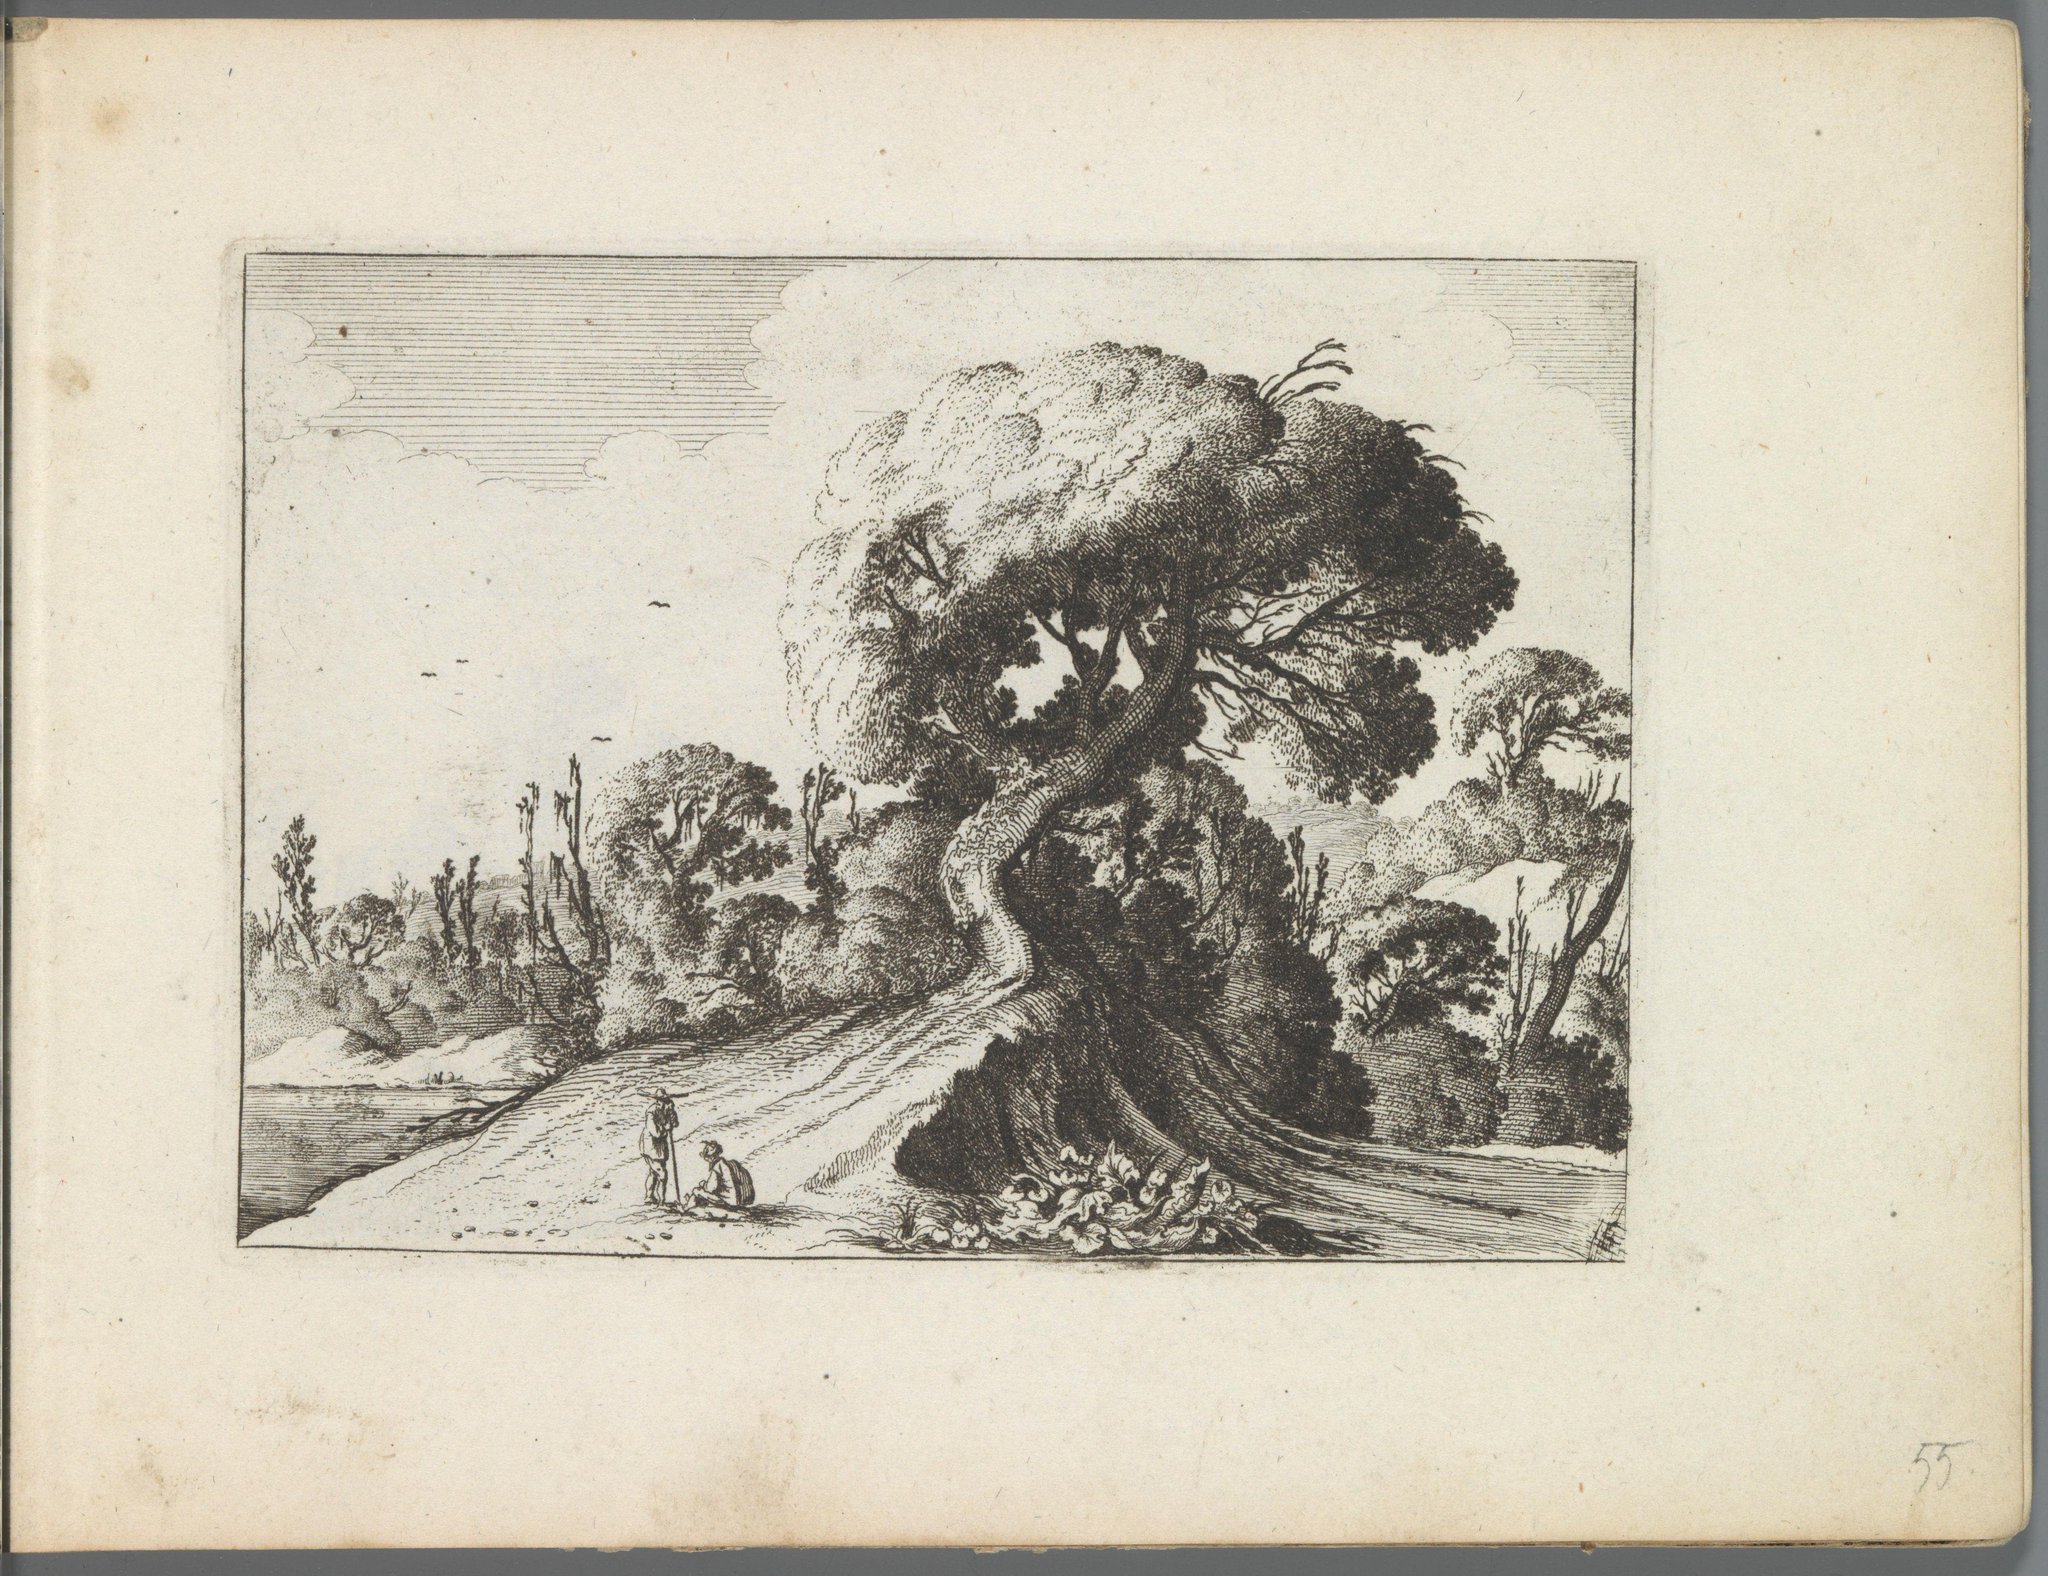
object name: album leaf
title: Twee mannen voor een grote boom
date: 1605-1653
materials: paper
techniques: etching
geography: amsterdam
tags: trees, (traveller) resting in the open air, forest, wood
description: Op een pad voor een grote boom bevinden zich twee mannen, de een zit en de ander leunt op zijn wandelstok. Op de achtergrond een bosrand. Rechtsonder genummerd: 5. De prent maakt deel uit van een album.